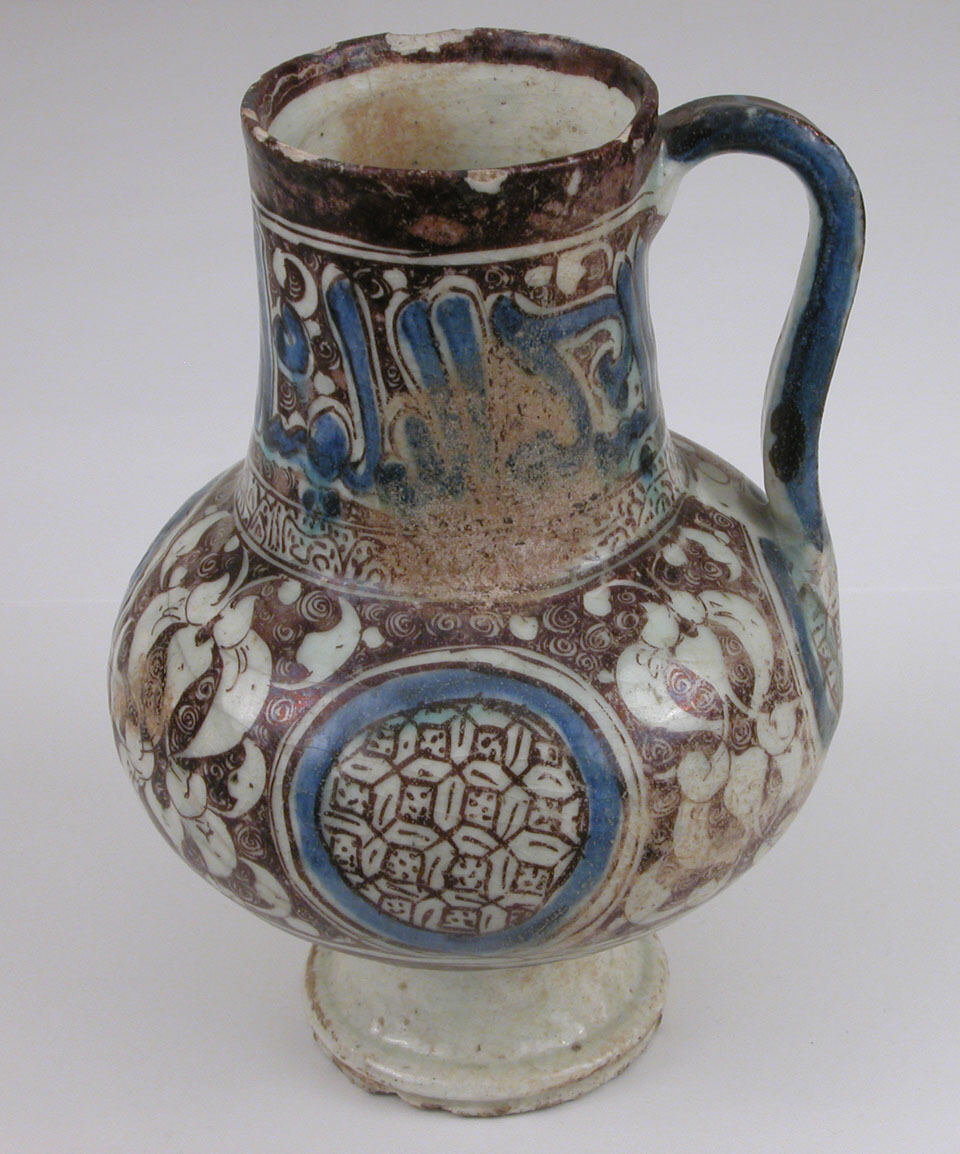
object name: ewer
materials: glaze, stonepaste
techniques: painting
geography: syria